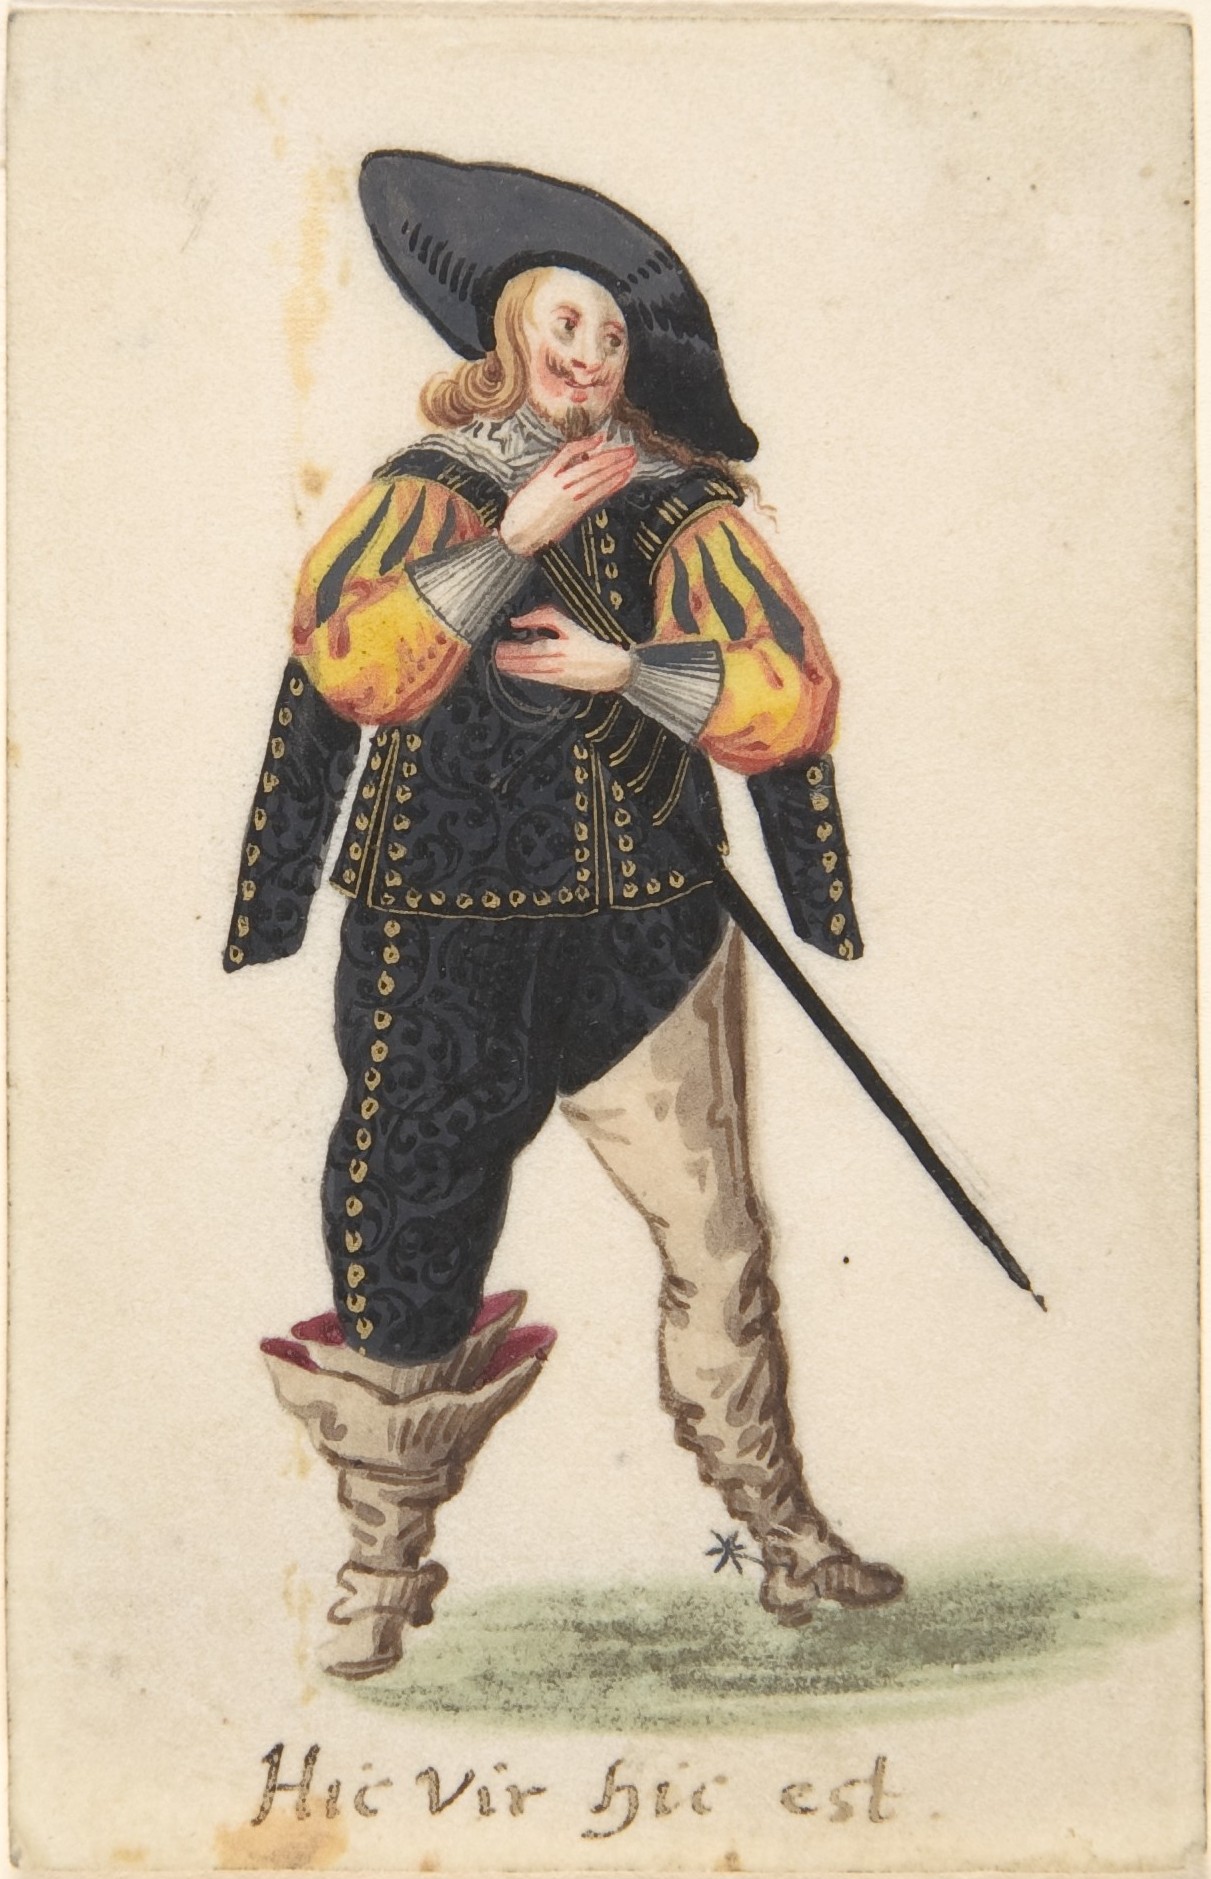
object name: drawing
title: A Standing Cavalier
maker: anonymous, swiss, late 16th to early 17th century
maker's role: artist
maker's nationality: swiss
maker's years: 1550-1650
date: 1567-1633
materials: gold paint, gouache, graphite, watercolor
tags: men